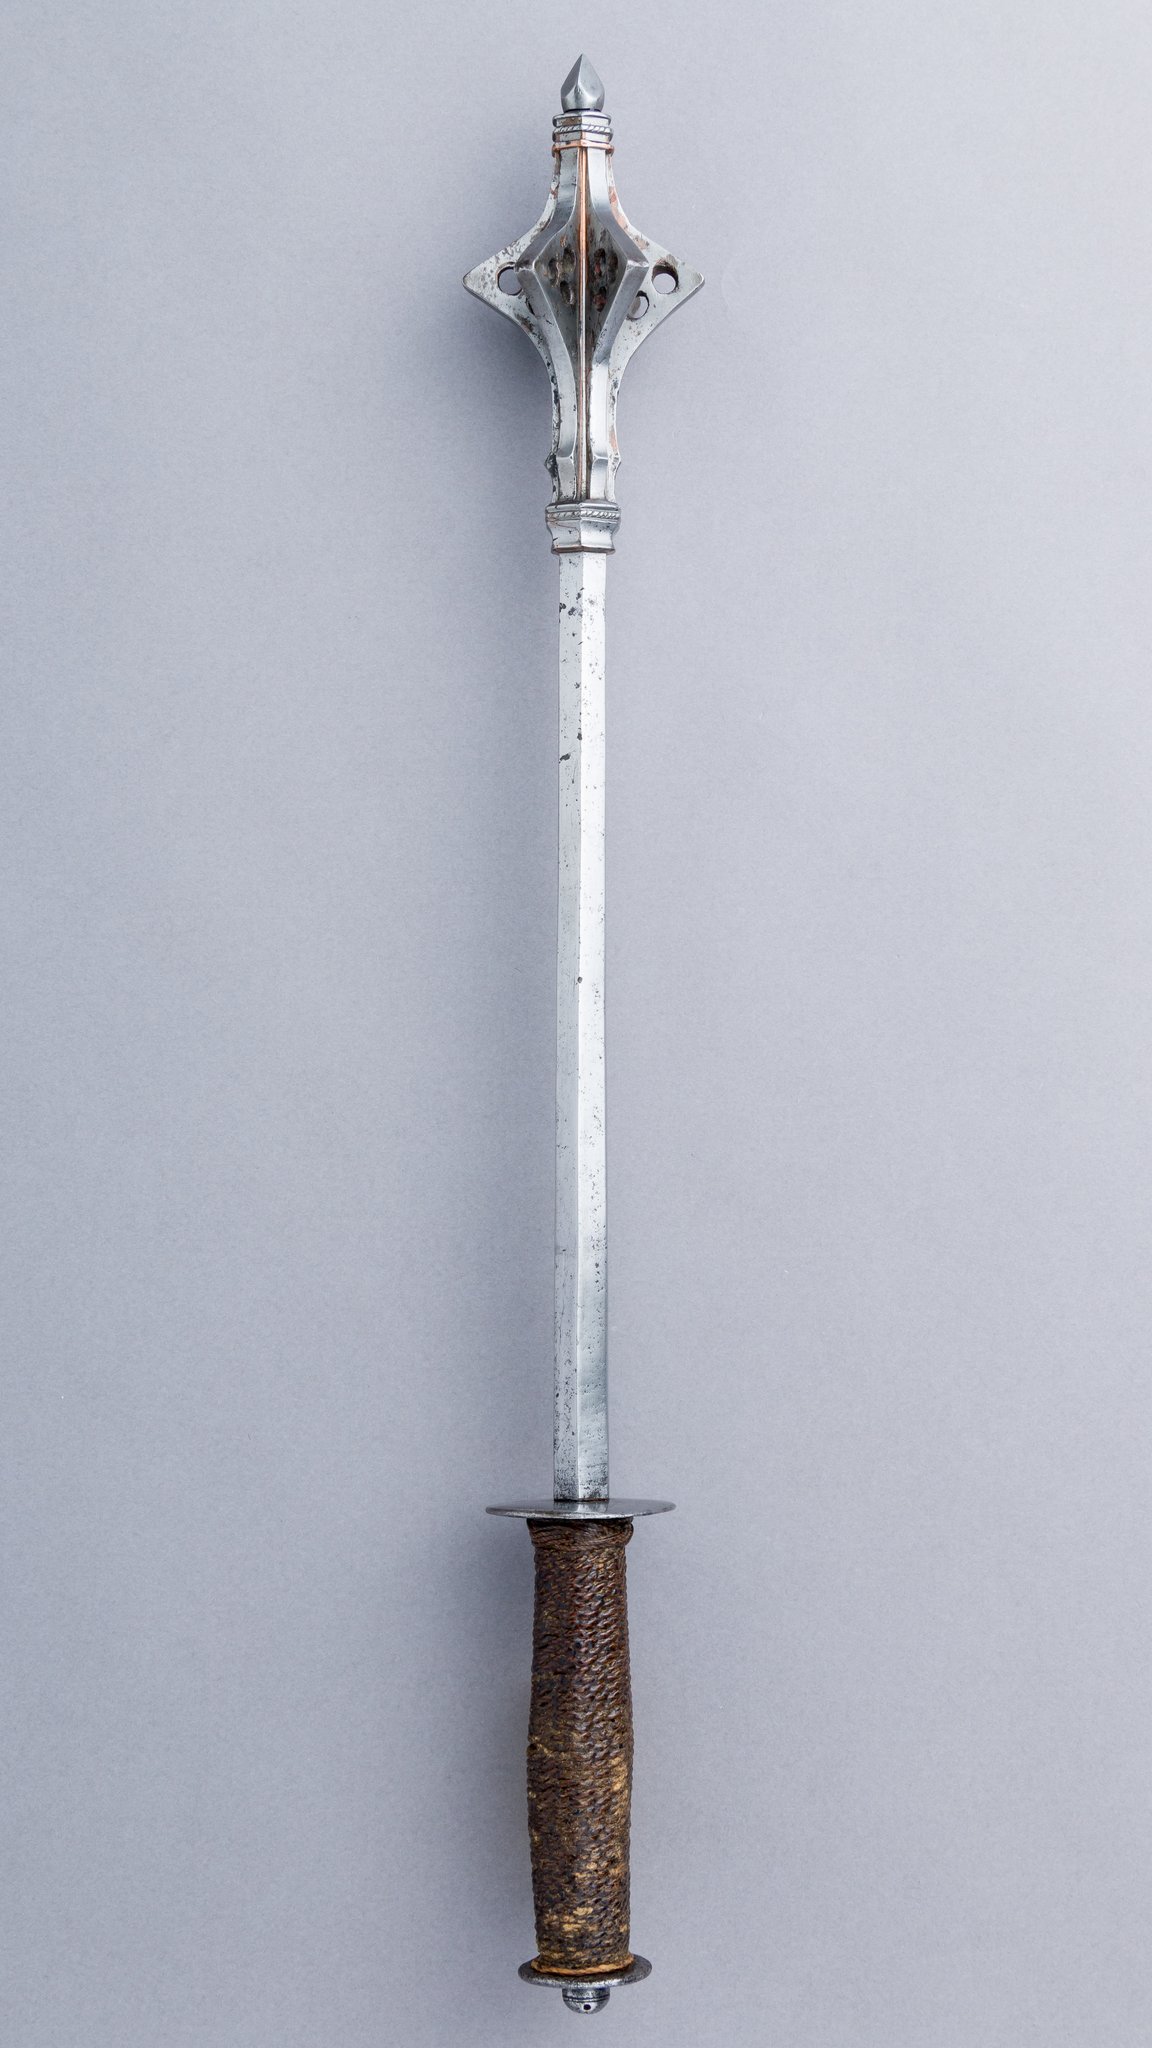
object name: mace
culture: french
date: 1467-1500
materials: fiber, steel, wood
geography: france